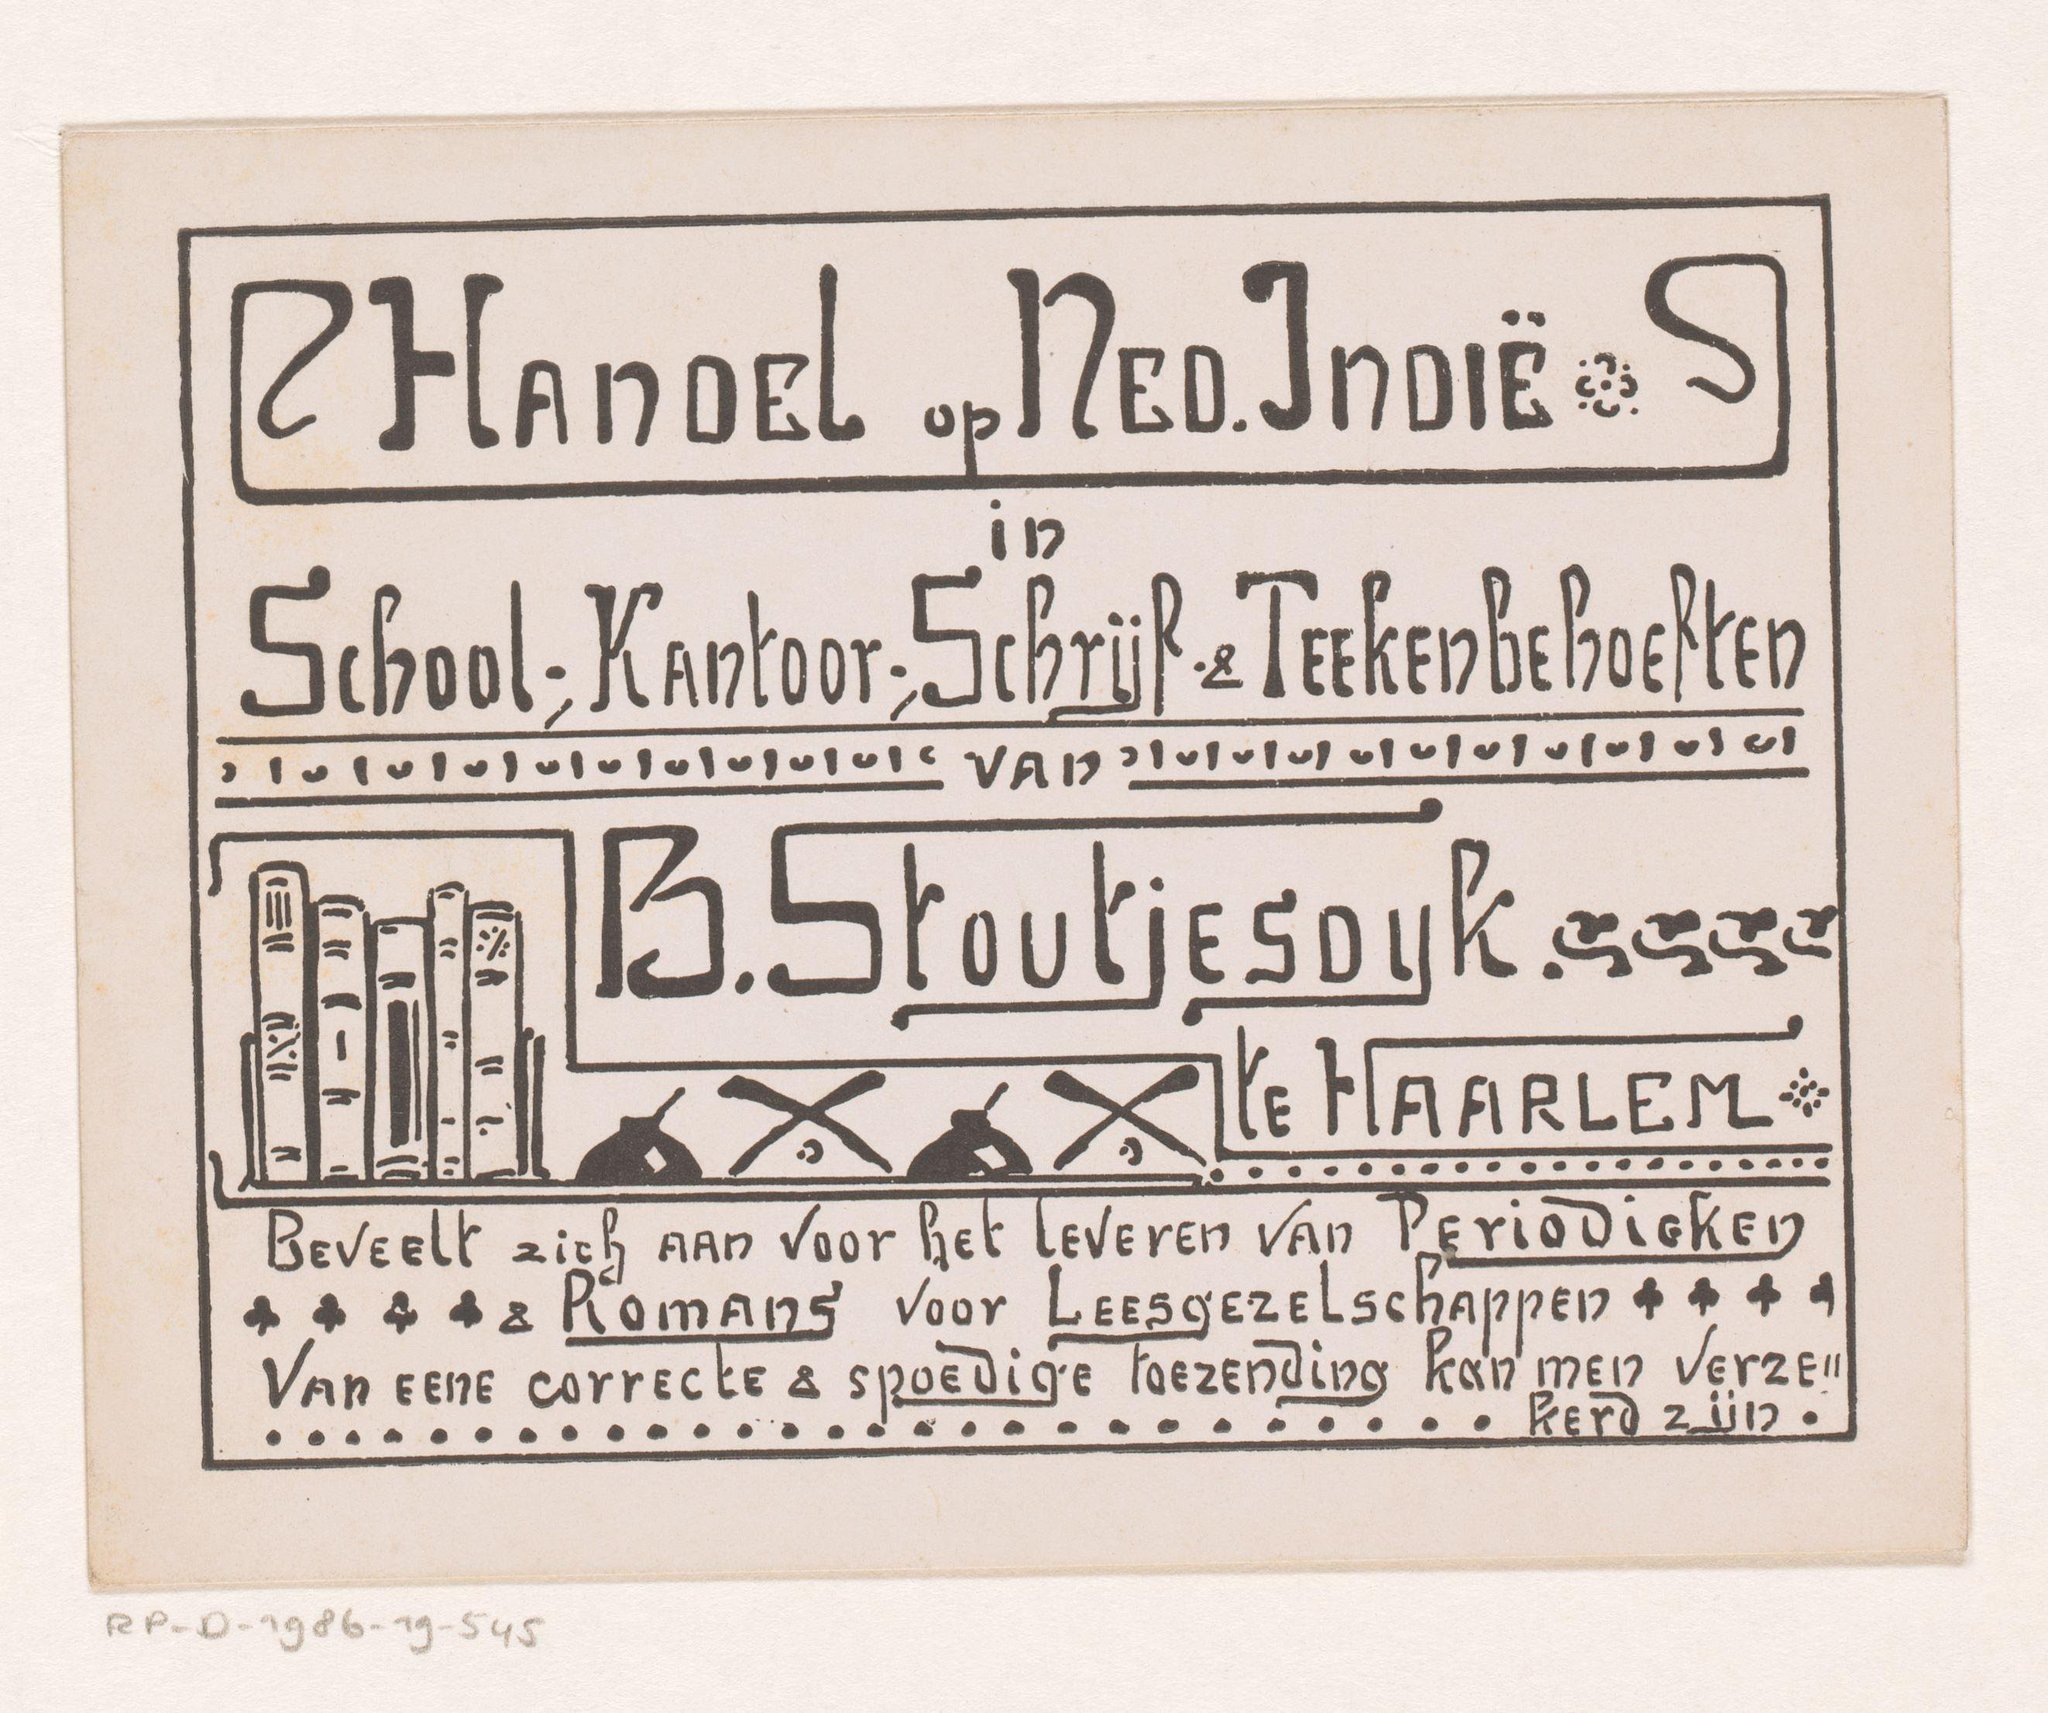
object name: photomechanical print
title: Advertentie van B. Stoutjesdijk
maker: reinier willem petrus de vries (1874-1953)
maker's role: draughtsman, print maker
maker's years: 1874-1953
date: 1895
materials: paper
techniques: printing block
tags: ink-well, pen, book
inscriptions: collector's mark: ‘R:MVS.’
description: Visitekaartje met boeken en schrijfgerei.